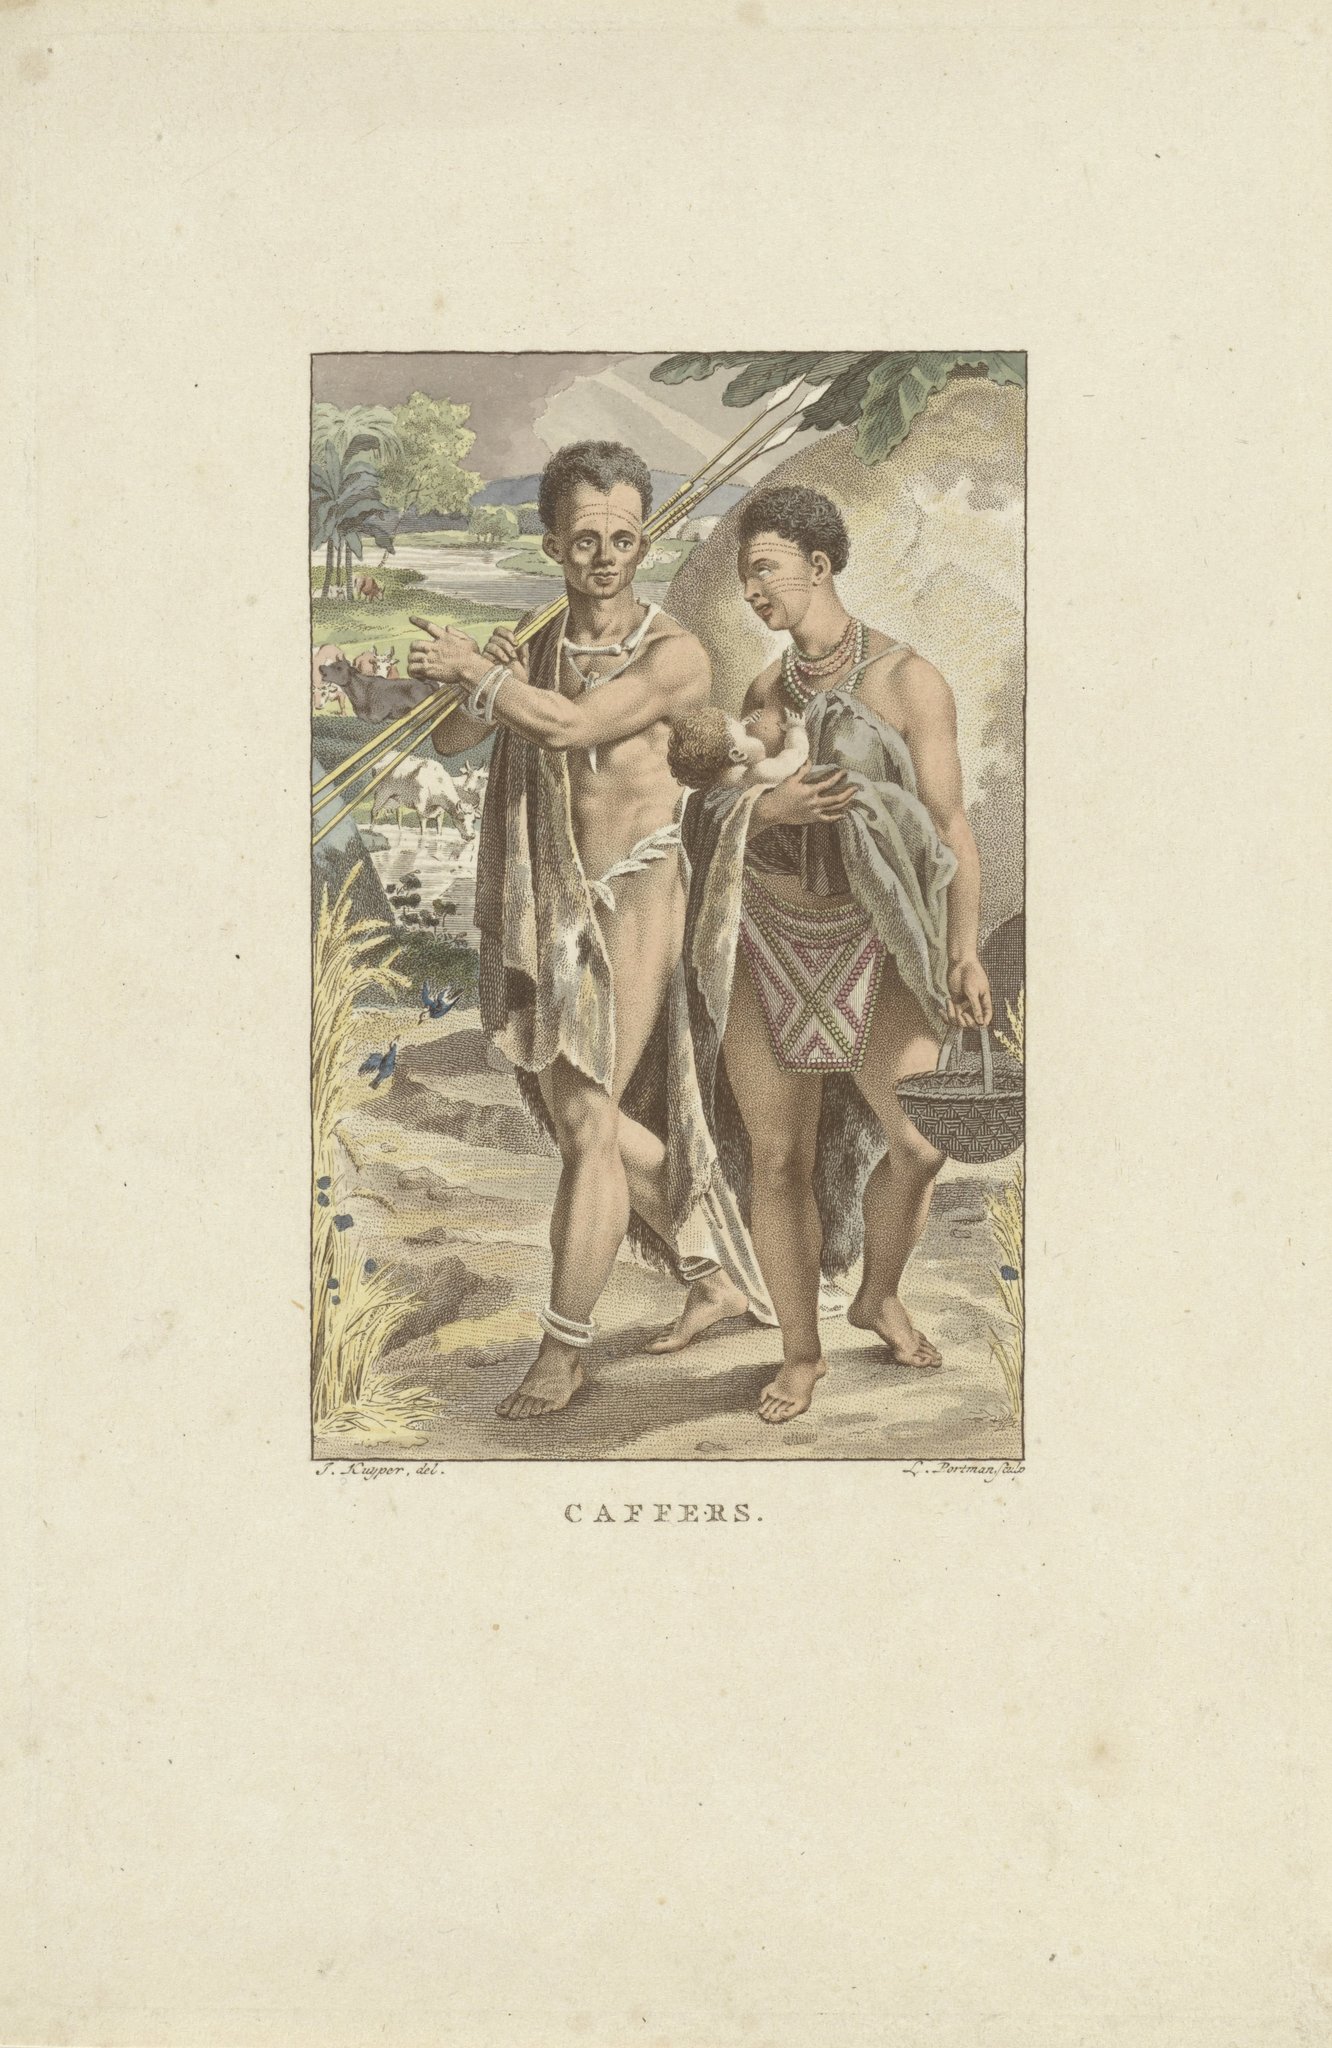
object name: print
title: Bewoners van zuidelijk Afrika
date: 1806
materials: paper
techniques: etching, hand coloring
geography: amsterdam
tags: nursing, suckling, human races; peoples; nationalities (+ costume)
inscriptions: collector's mark: Lugt 2228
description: Een man en vrouw verlaten hun hut. De vrouw geeft haar kind de borst. In haar hand houdt ze een mand om de melk van de koeien in op te vangen. Op de achtergrond is de akker met koeien zichtbaar.